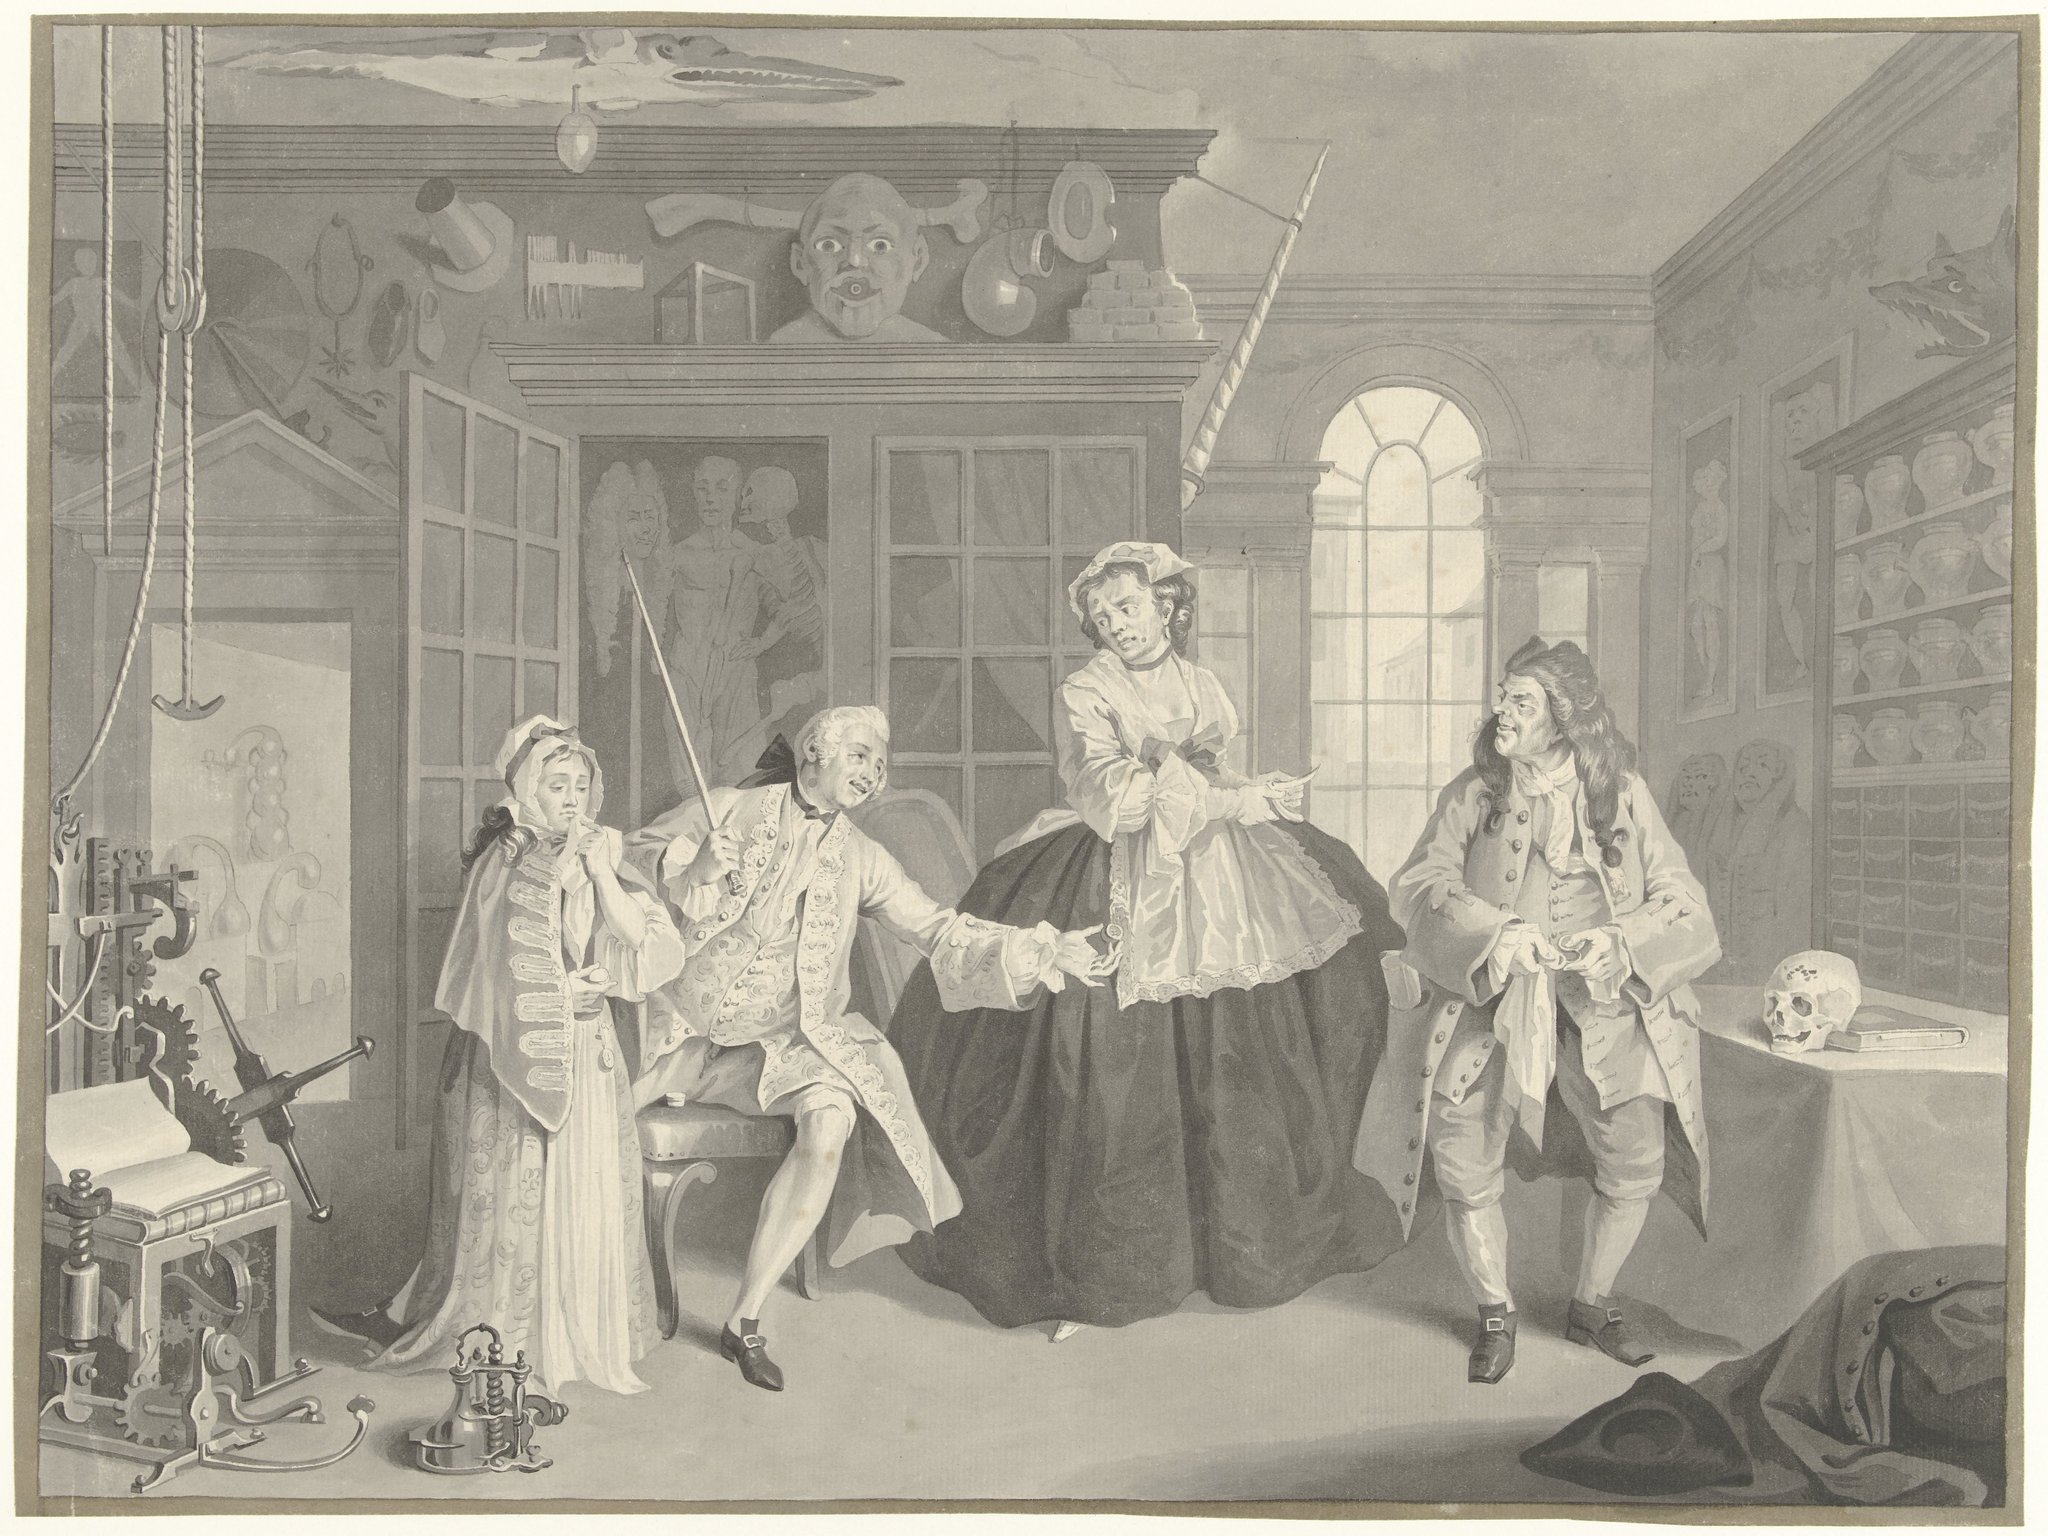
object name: drawing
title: Verbeeld een pokmeester en zijn vrouw in hun winkel (...)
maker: cornelis ploos van amstel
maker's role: draughtsman, print maker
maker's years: 1726-1798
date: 1748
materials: ink, paper, pencil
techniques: brush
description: Blad 4 uit een serie van 6 bladen. Met apart opgezet en gedateerd inhoudsblad (volgens JWN in ander handschrift dan dat van Ploos van Amstel).